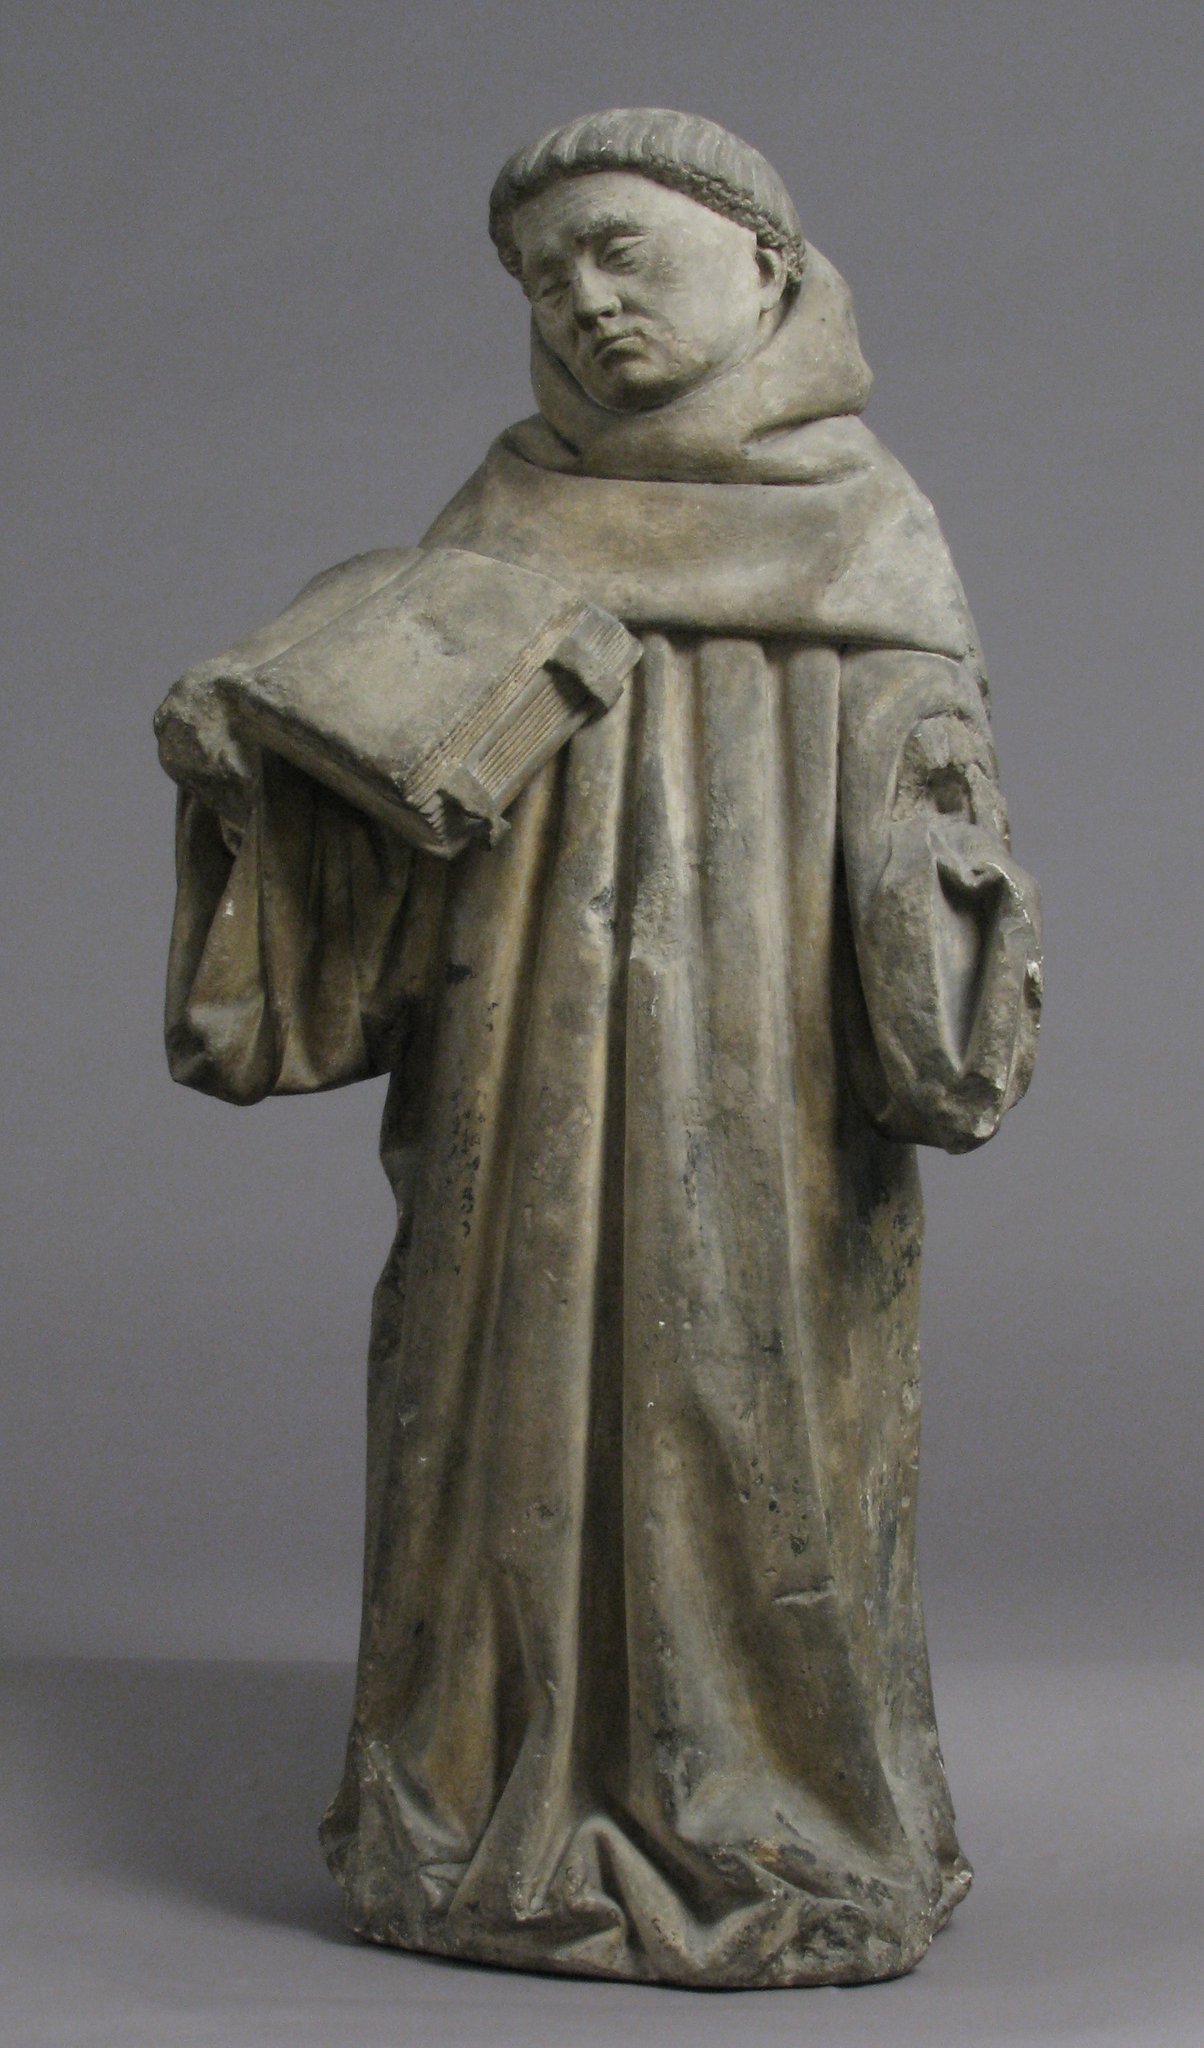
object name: statuette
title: Monk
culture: french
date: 1401-1500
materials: stone